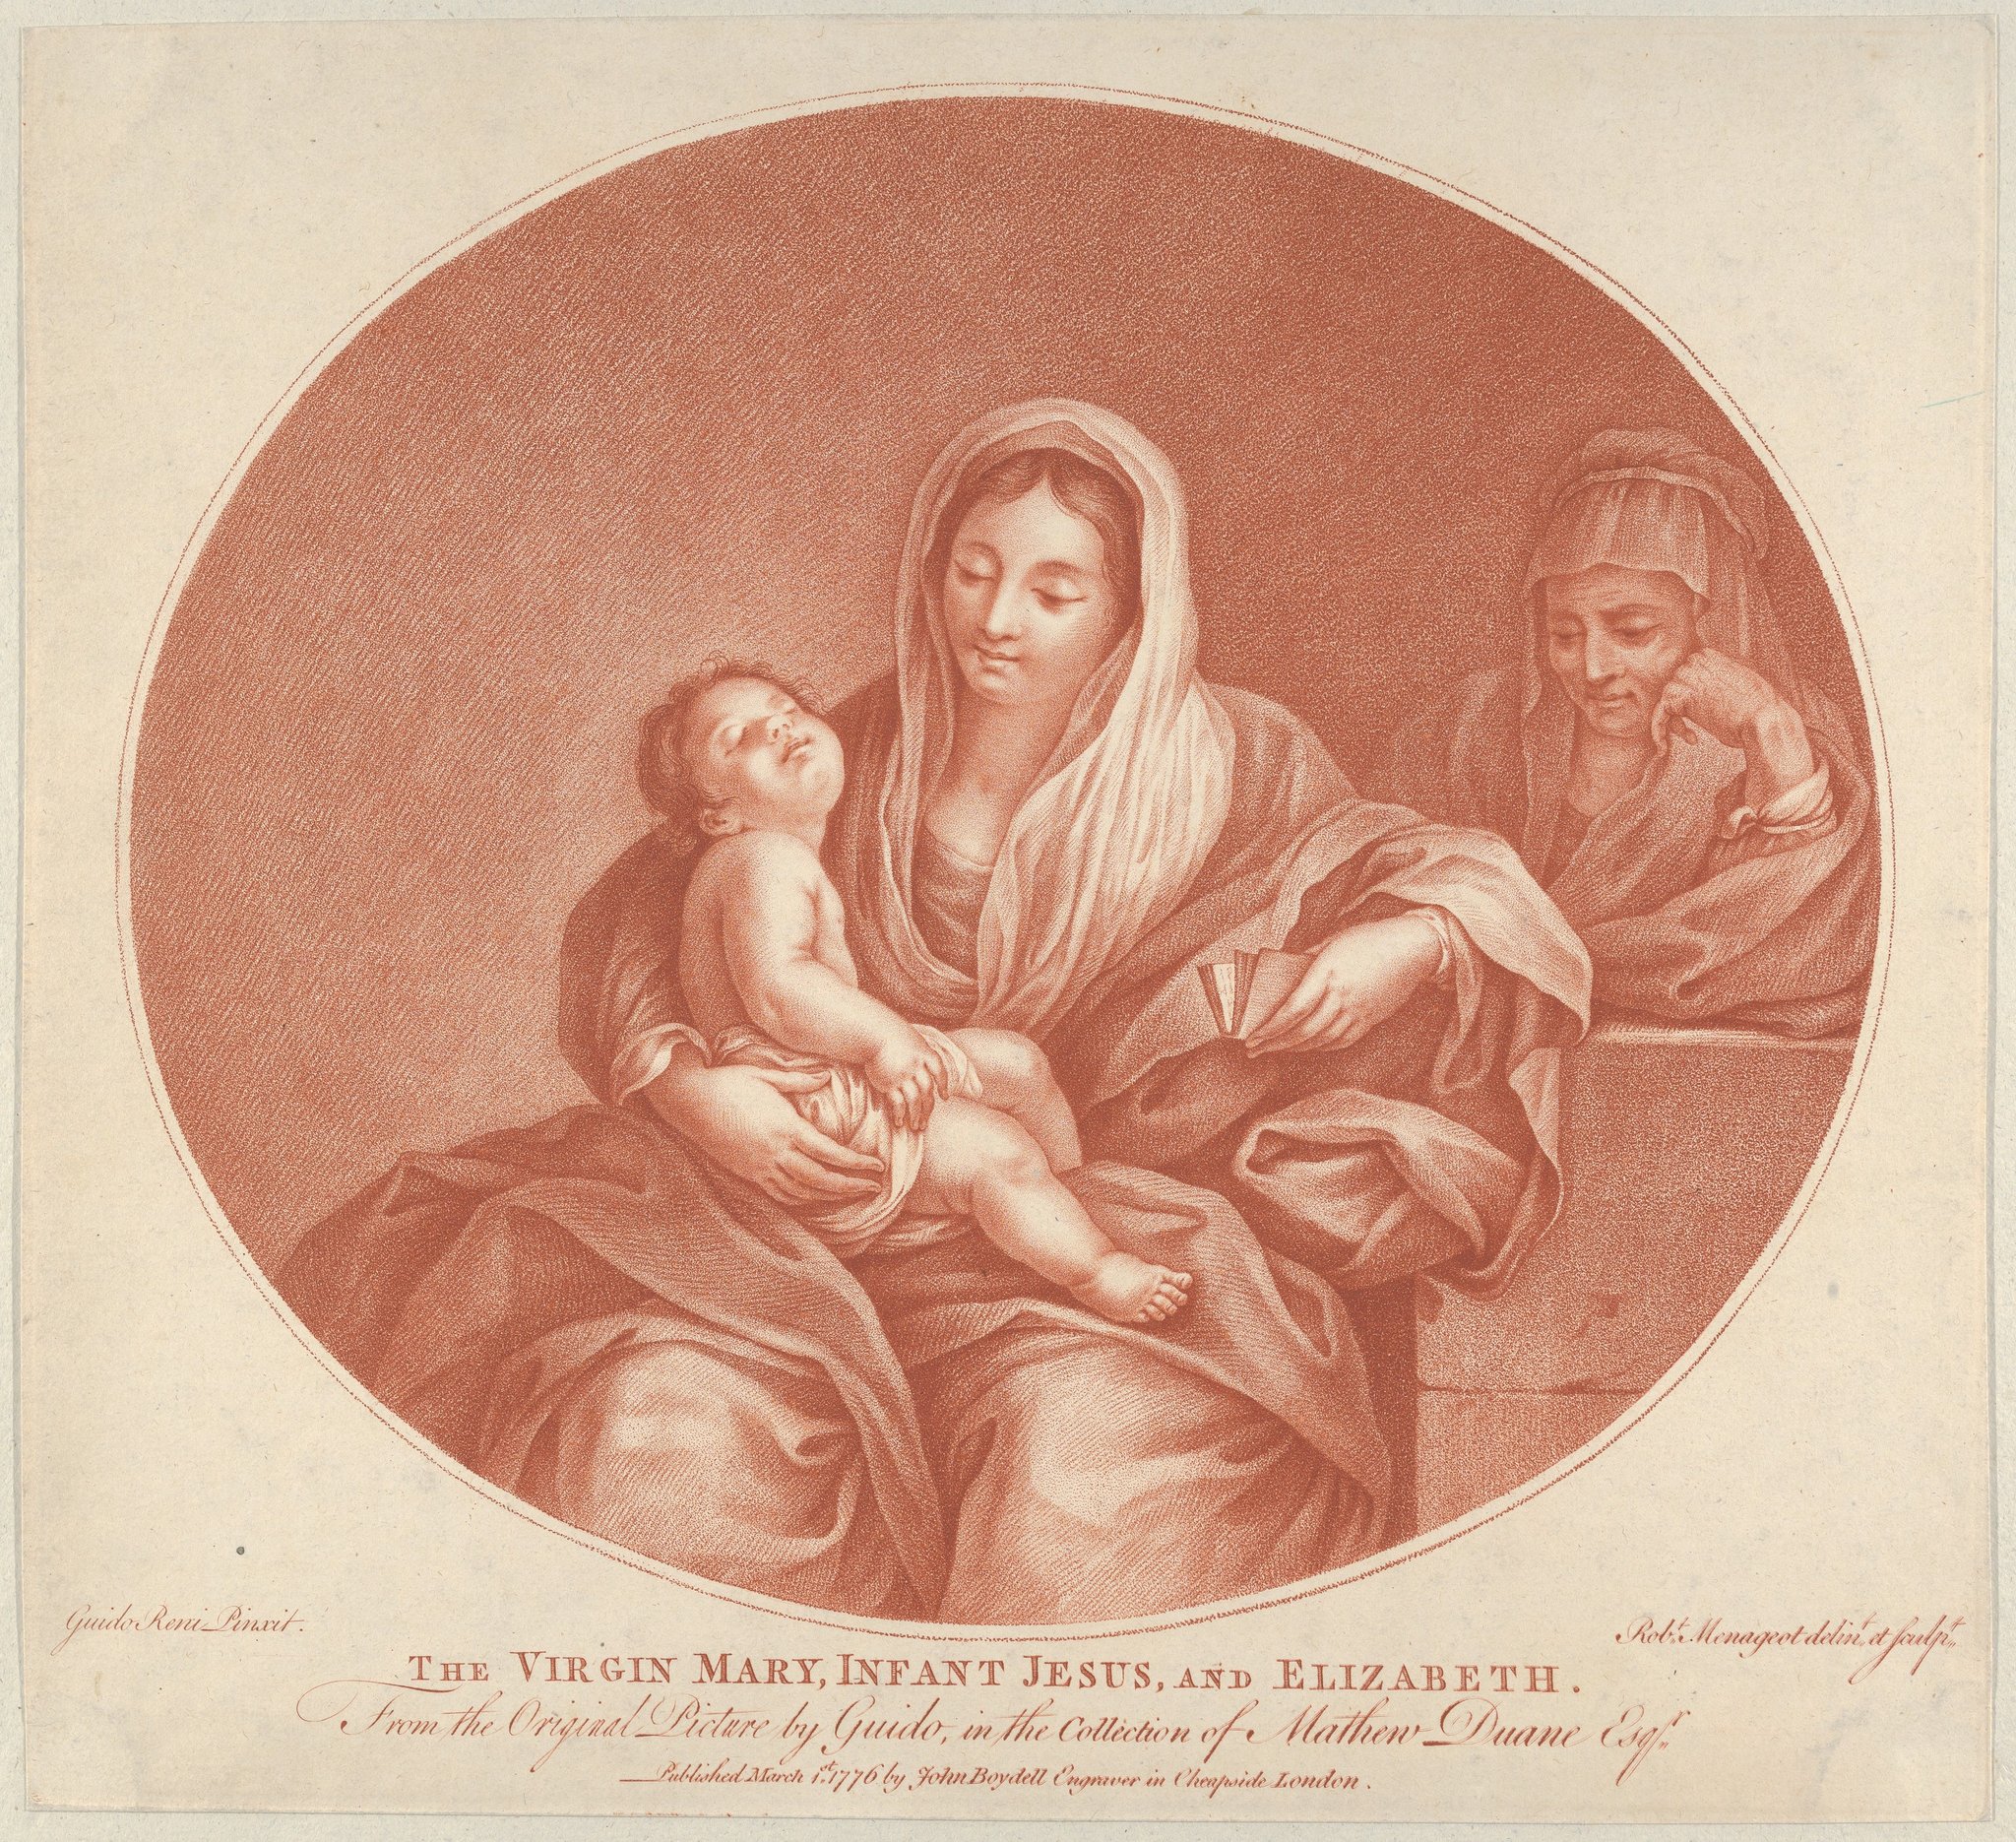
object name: print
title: The Virgin seated with the infant Christ sleeping in her lap, Saint Elizabeth at right, an oval composition, after Reni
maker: robert menageot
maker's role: artist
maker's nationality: french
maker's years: 1748-1808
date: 1776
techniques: printmaking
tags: love,sleeping,madonna and child,saints